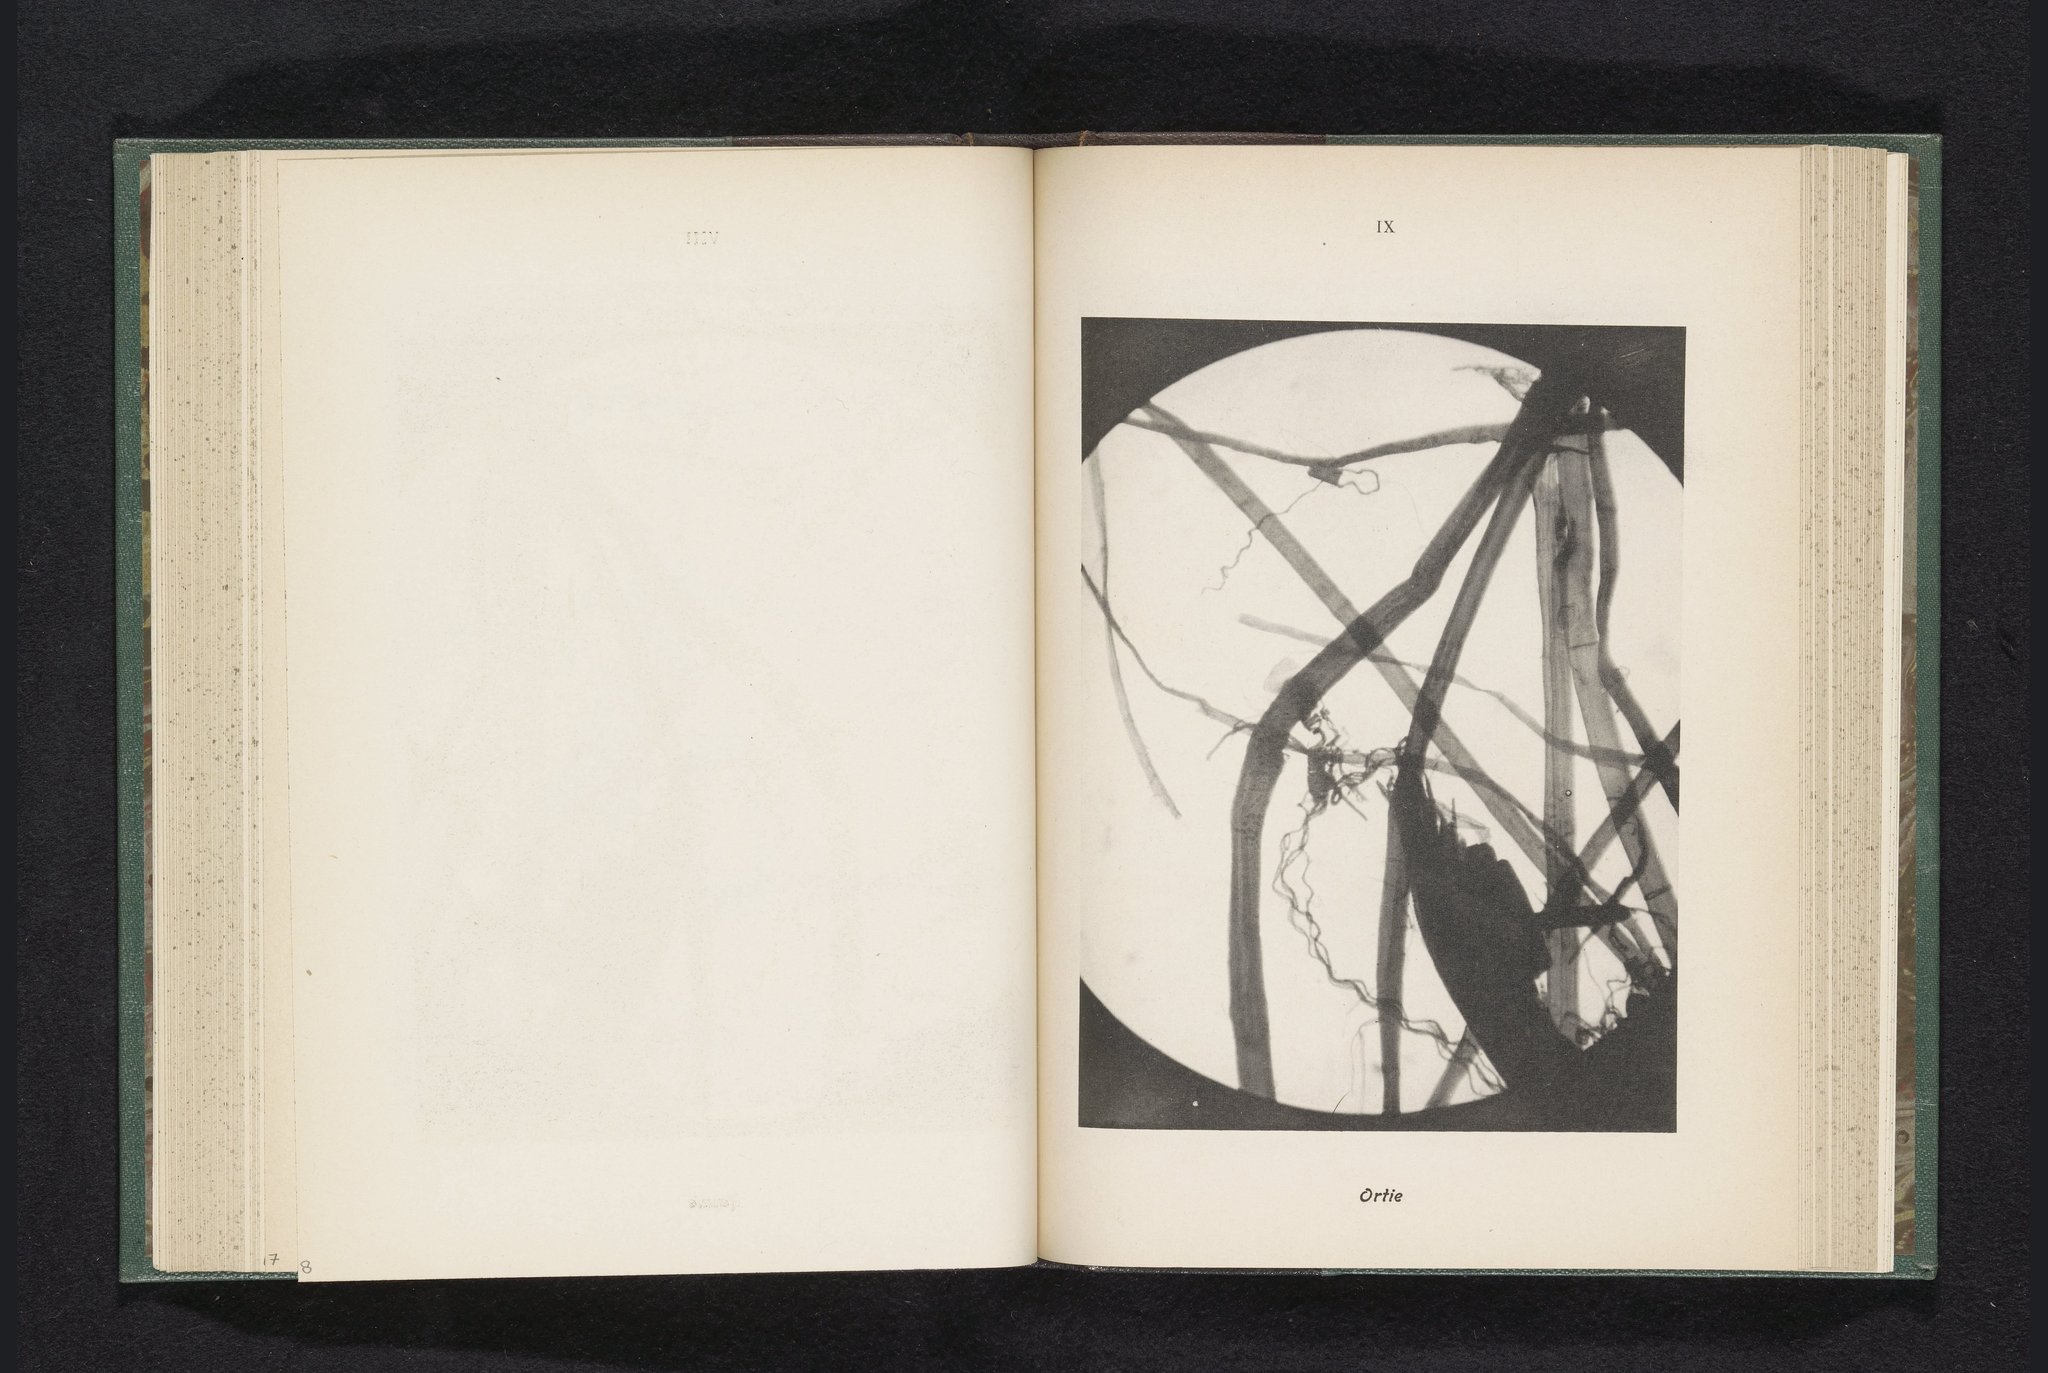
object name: photomechanical print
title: Ortie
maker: Anonymous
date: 1890-1900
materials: paper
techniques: photograph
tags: plants and herbs: nettle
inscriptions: number: ‘IX’